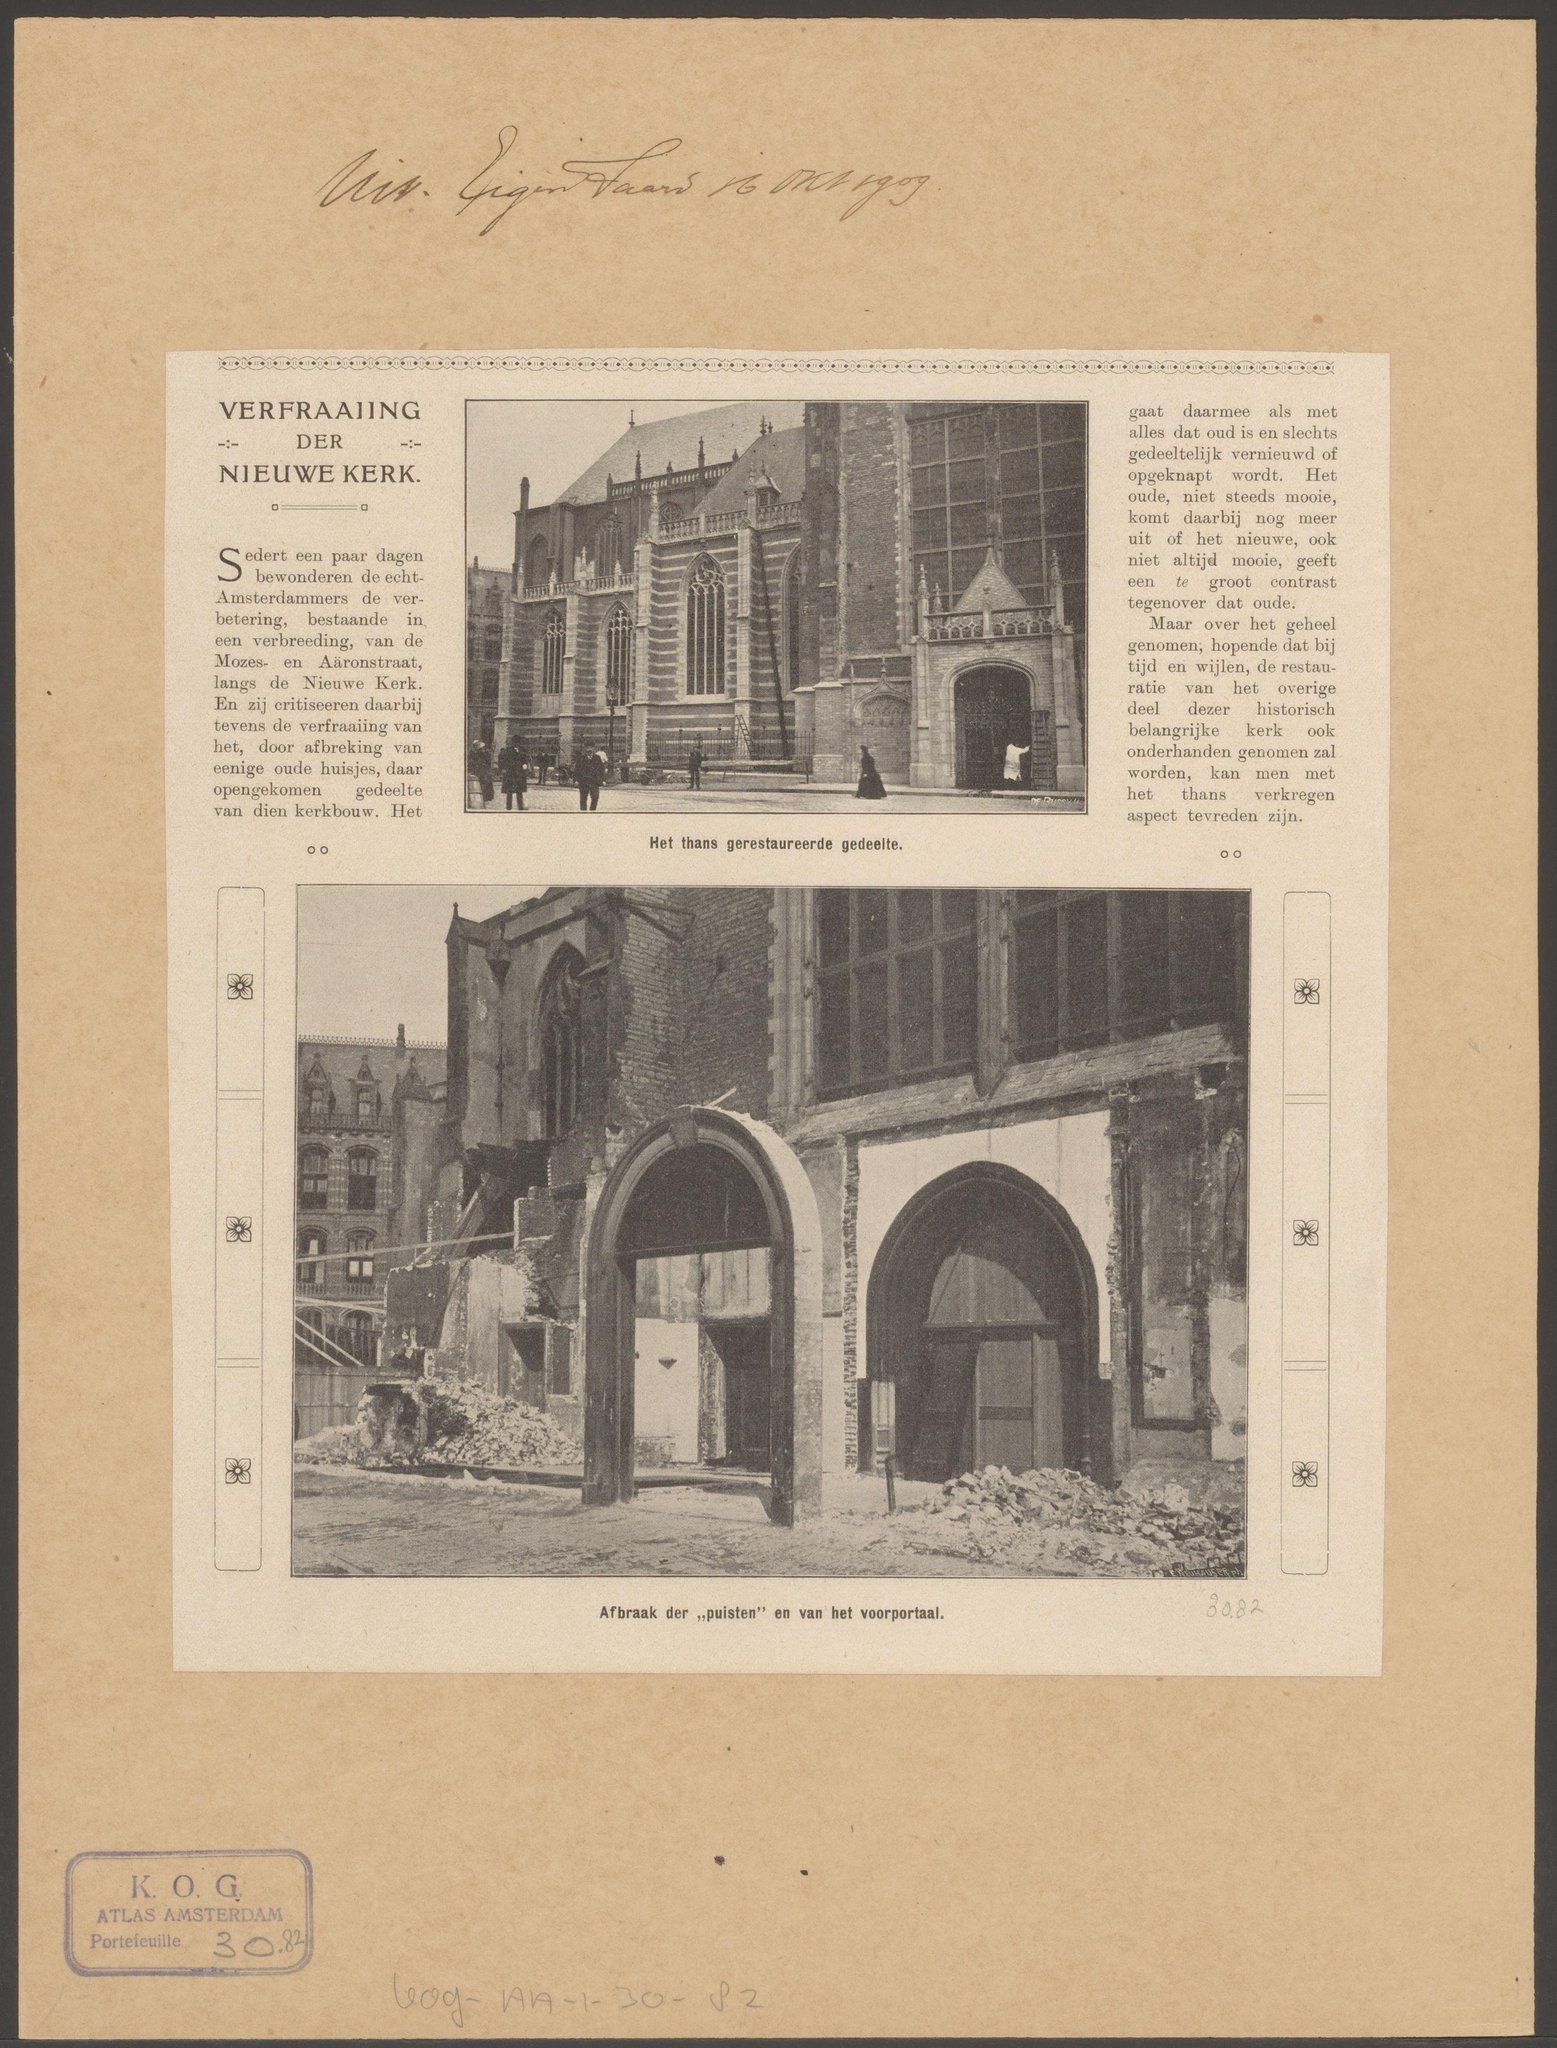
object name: photomechanical print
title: Verfraaiing der Nieuwe Kerk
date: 1909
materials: paper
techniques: letterpress printing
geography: amsterdam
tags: church (exterior), demolition of building, street (+ city(-scape) with figures, staffage)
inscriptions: collector's mark: Lugt 1641b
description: Onderwerpsrubriek binnen de Atlas Amsterdam: Kerkwezen: Hervormde Gemeente: Nieuwe Kerk van buiten.